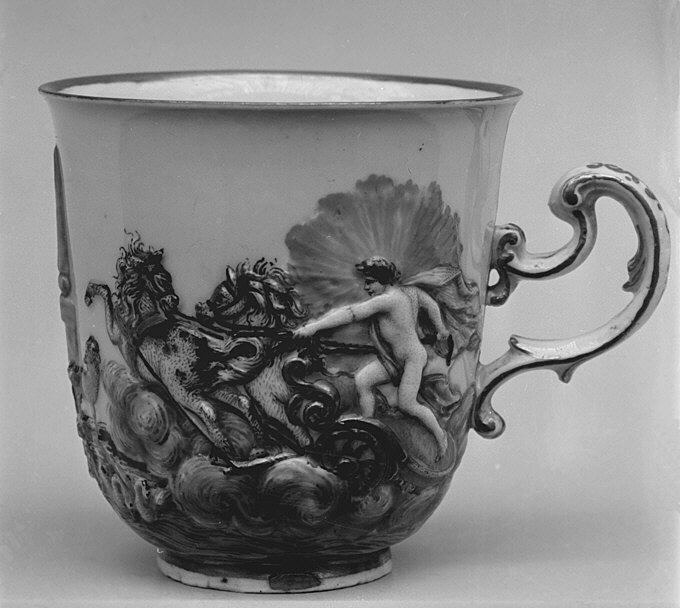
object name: coffee cup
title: Coffee cup (part of a service)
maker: doccia porcelain manufactory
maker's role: manufactory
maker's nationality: italian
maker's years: 1737-1896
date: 1760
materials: hard paste porcelain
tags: male nudes,horses